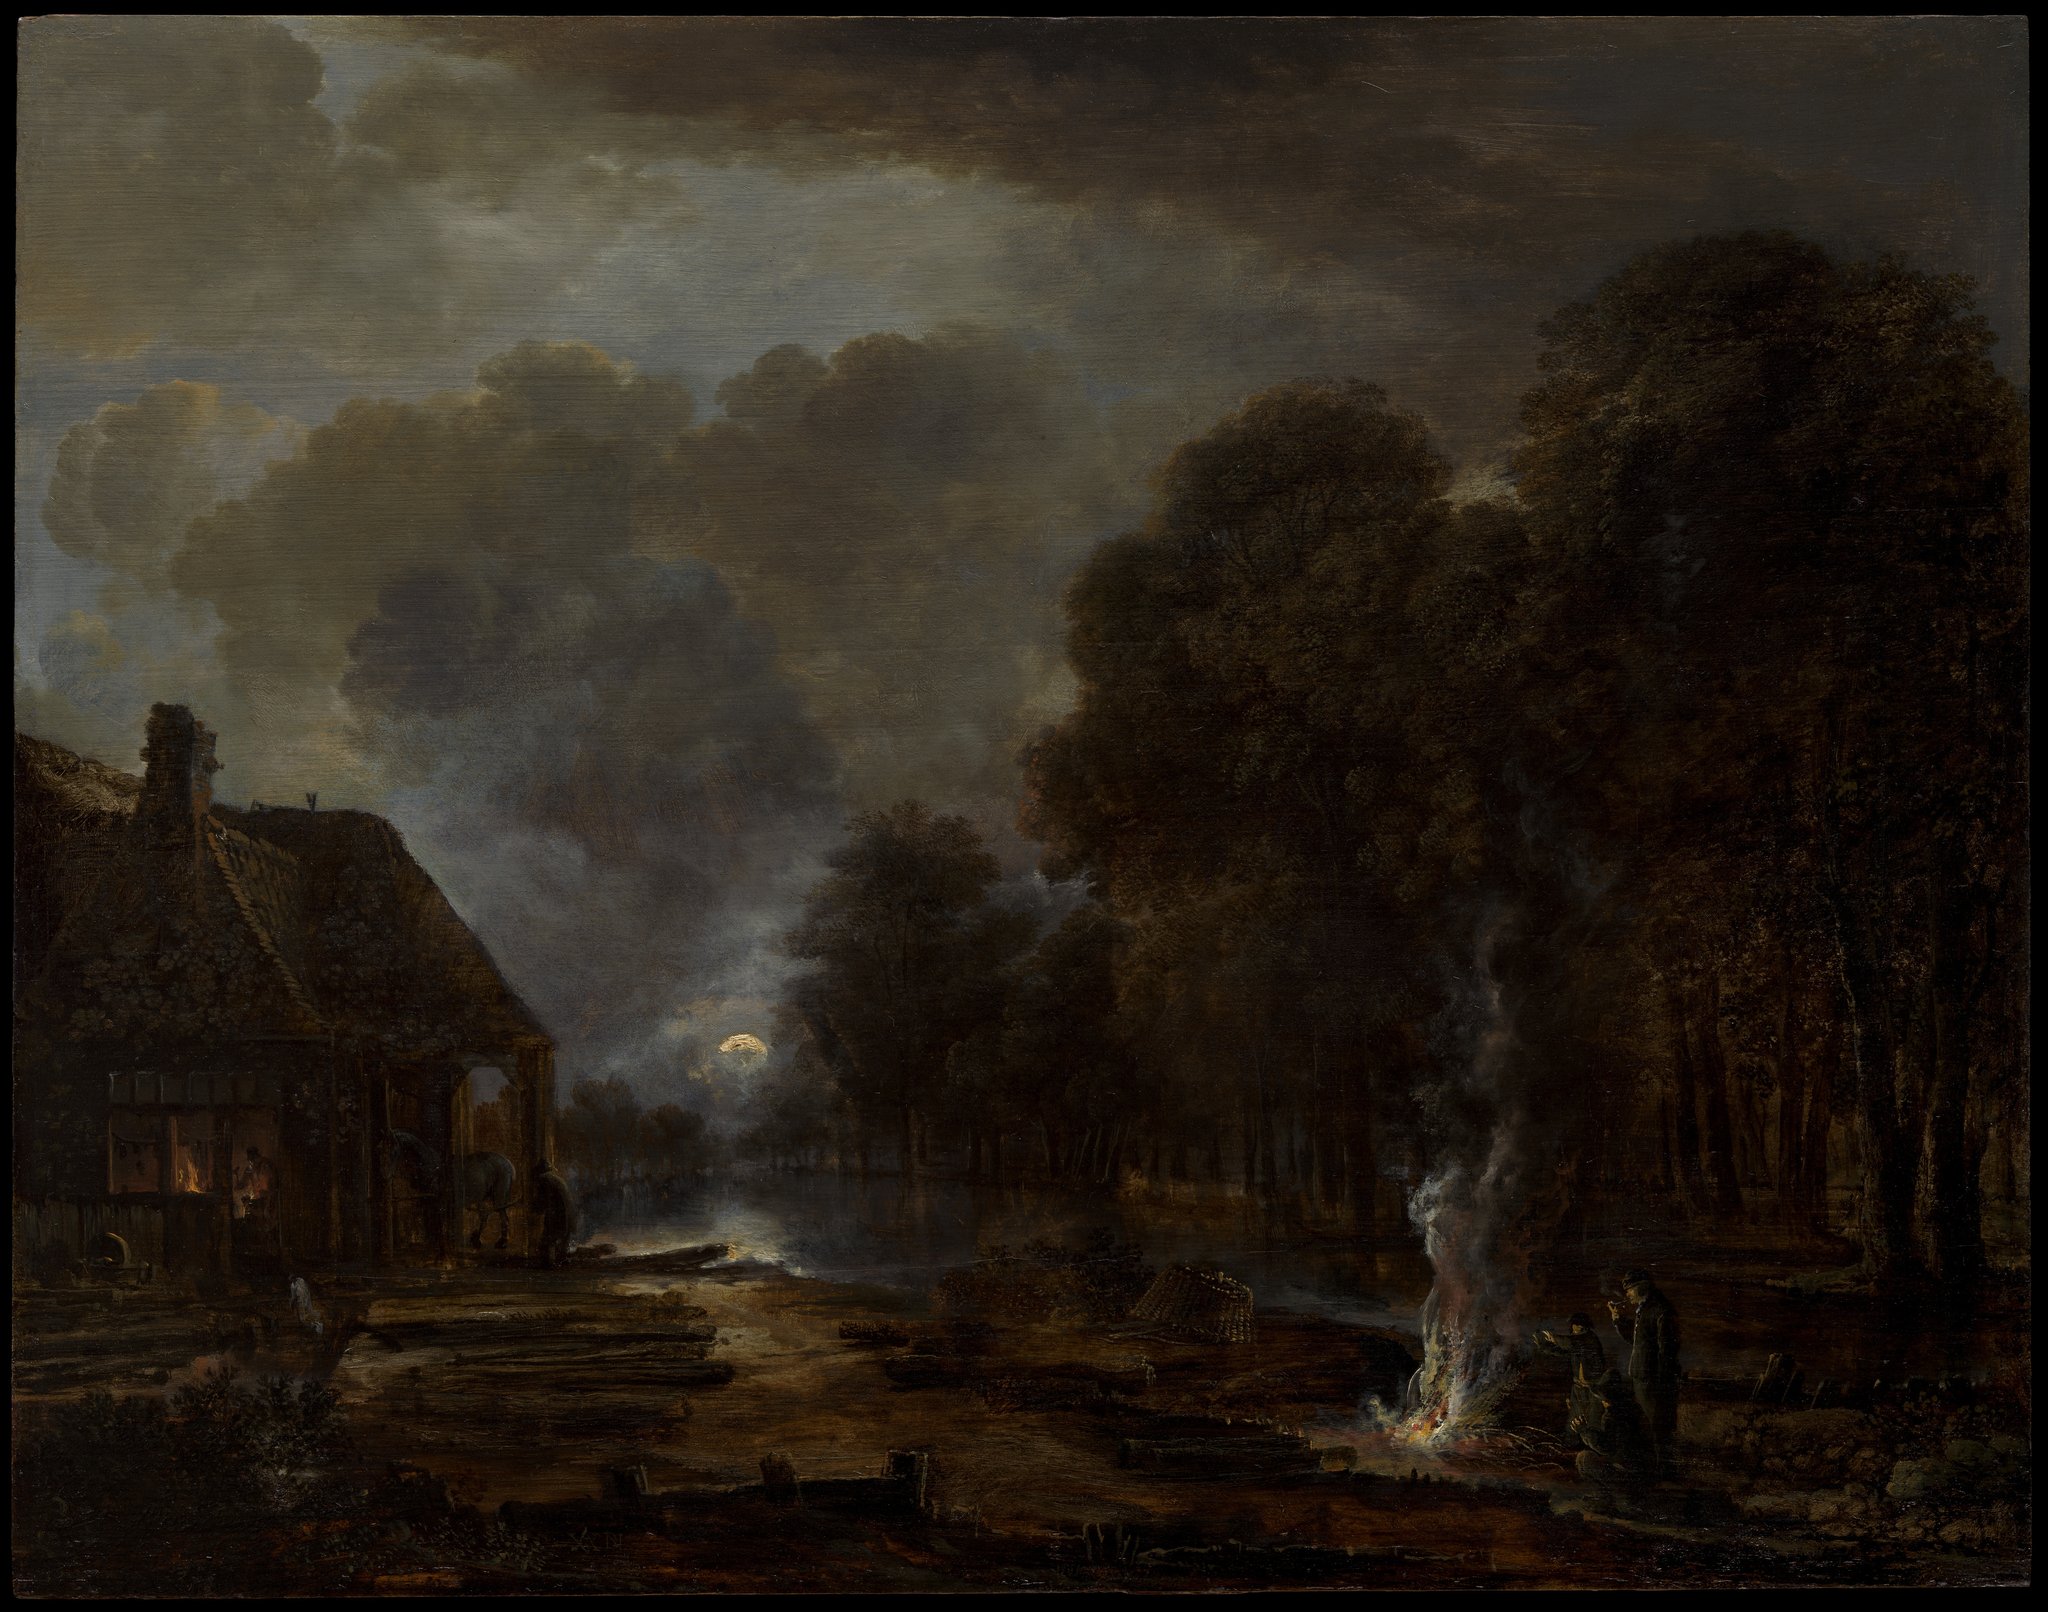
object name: painting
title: The Farrier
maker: aert van der neer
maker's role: artist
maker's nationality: dutch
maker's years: 1603-1677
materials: oil, wood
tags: fire,landscapes,night,blacksmiths